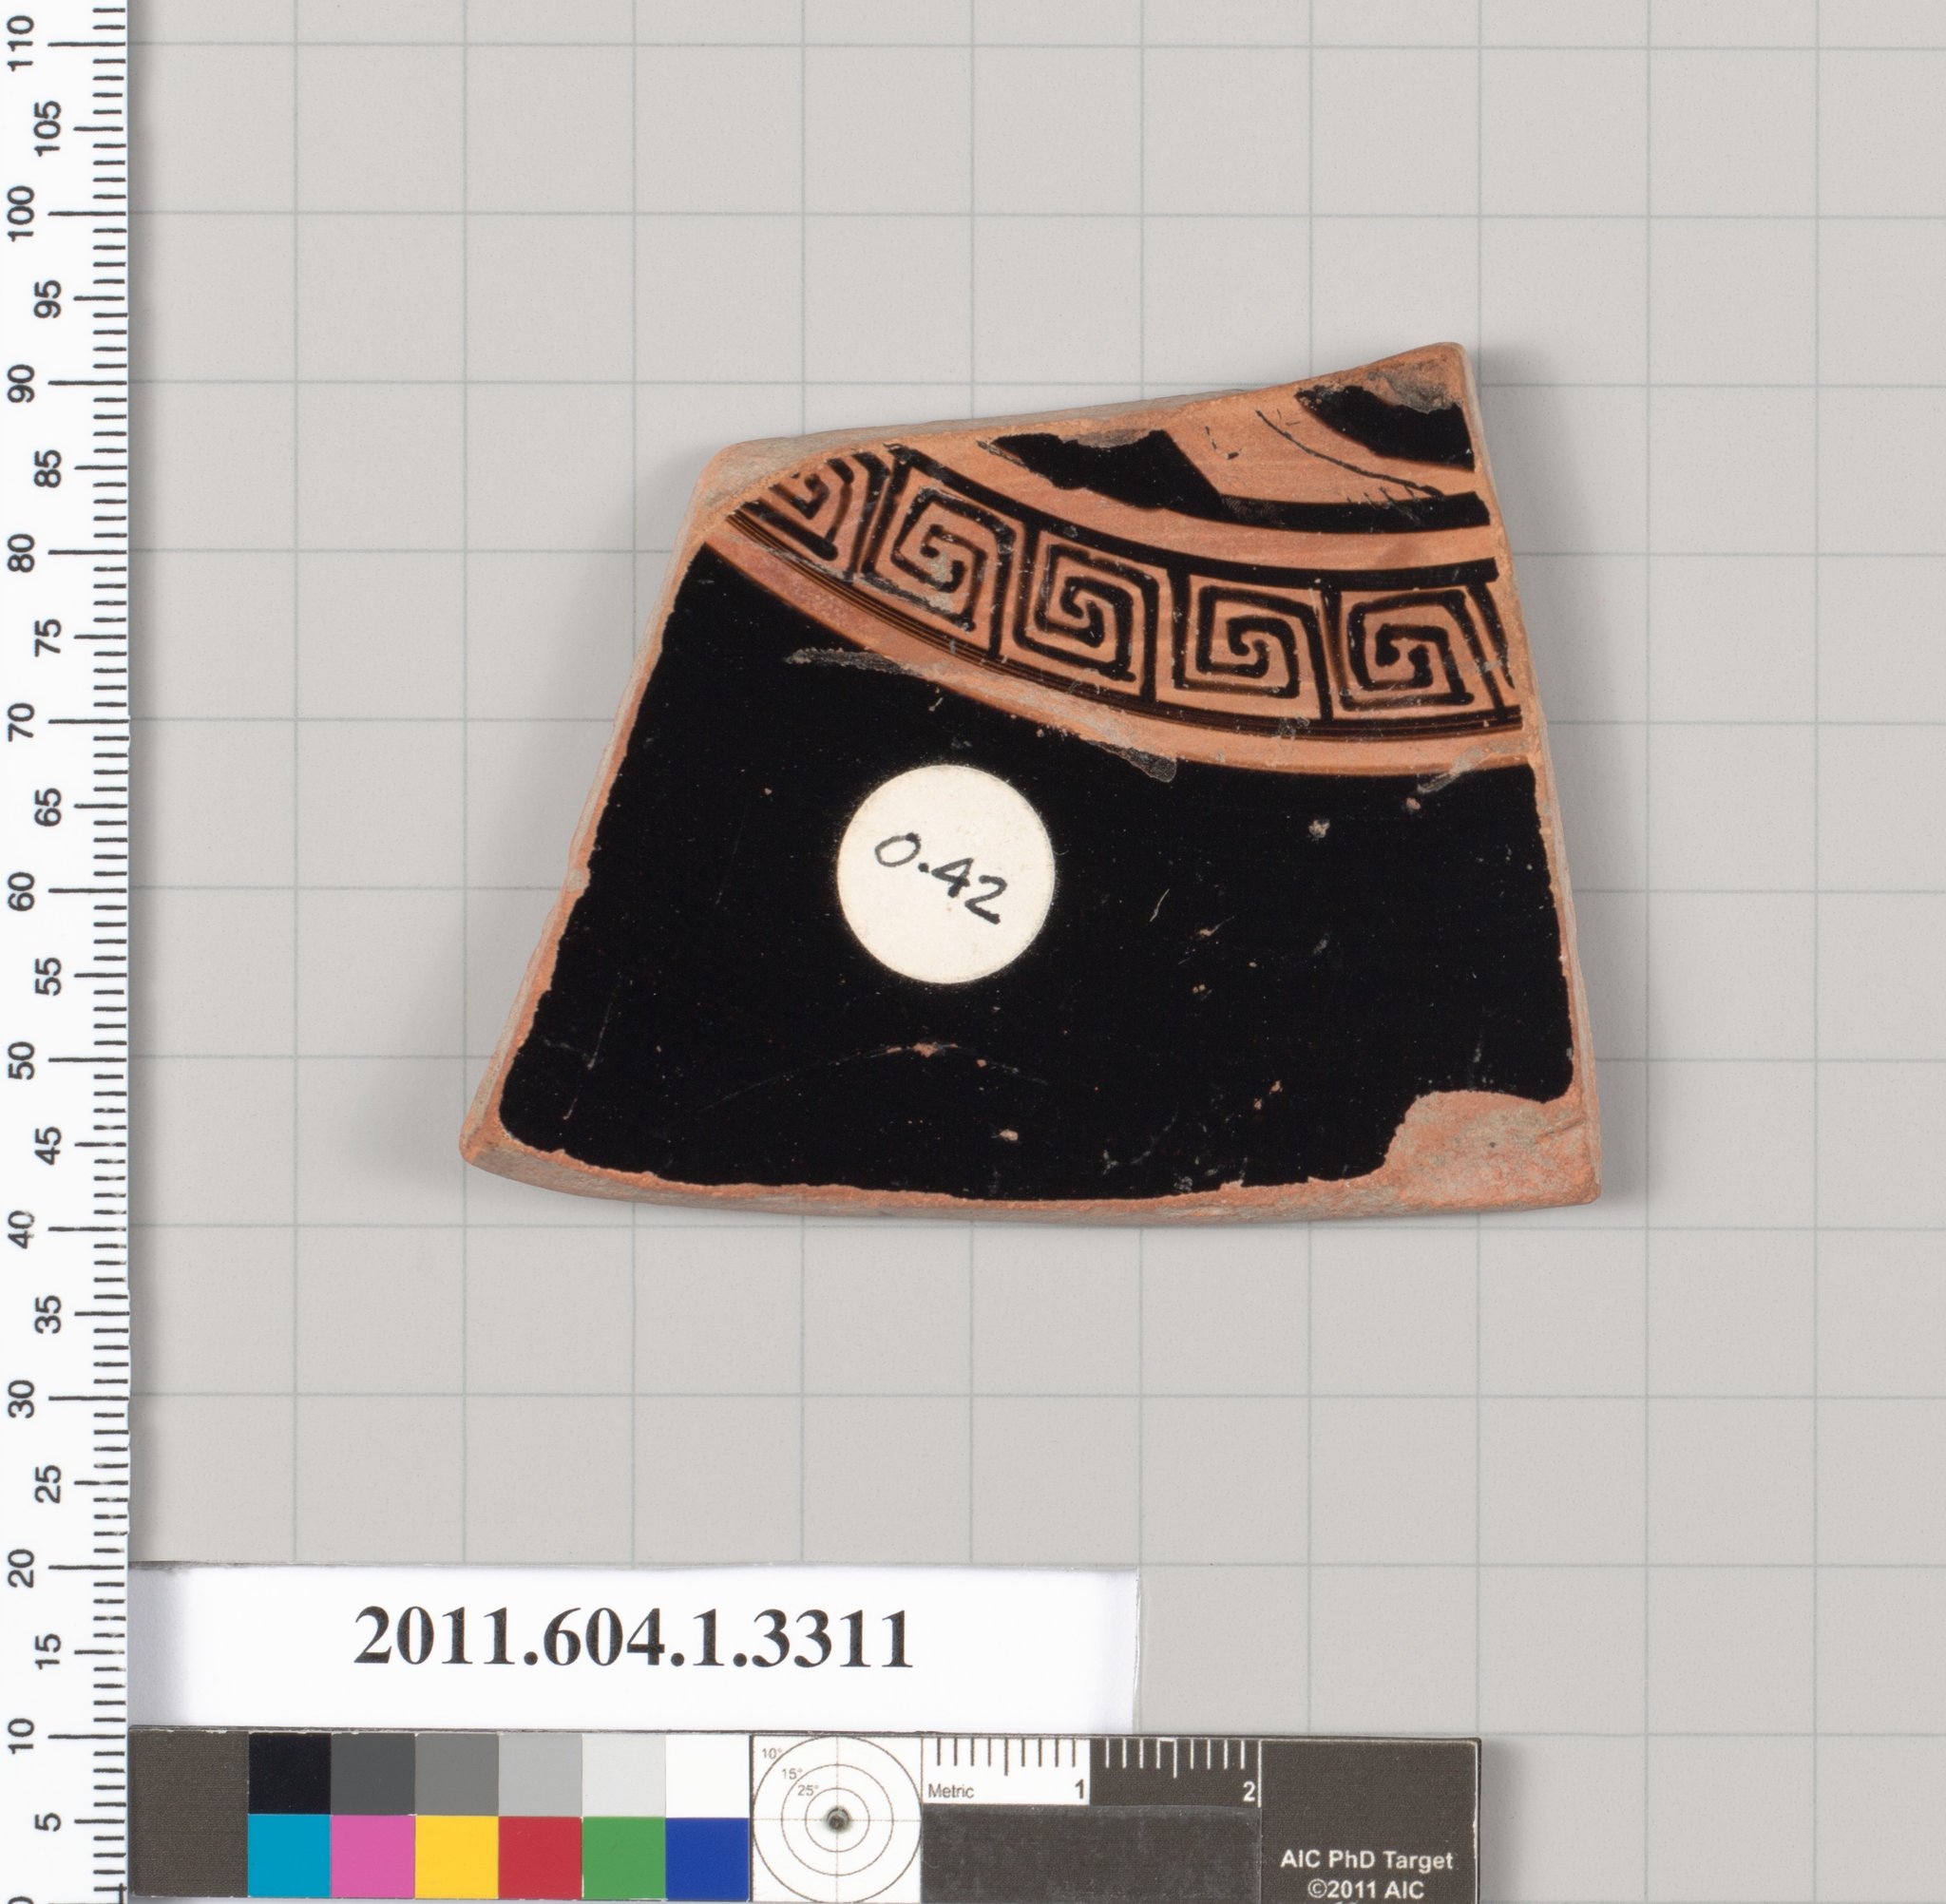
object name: kylix fragment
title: Terracotta fragment of a kylix (drinking cup)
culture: greek, attic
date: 475-451 BCE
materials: terracotta